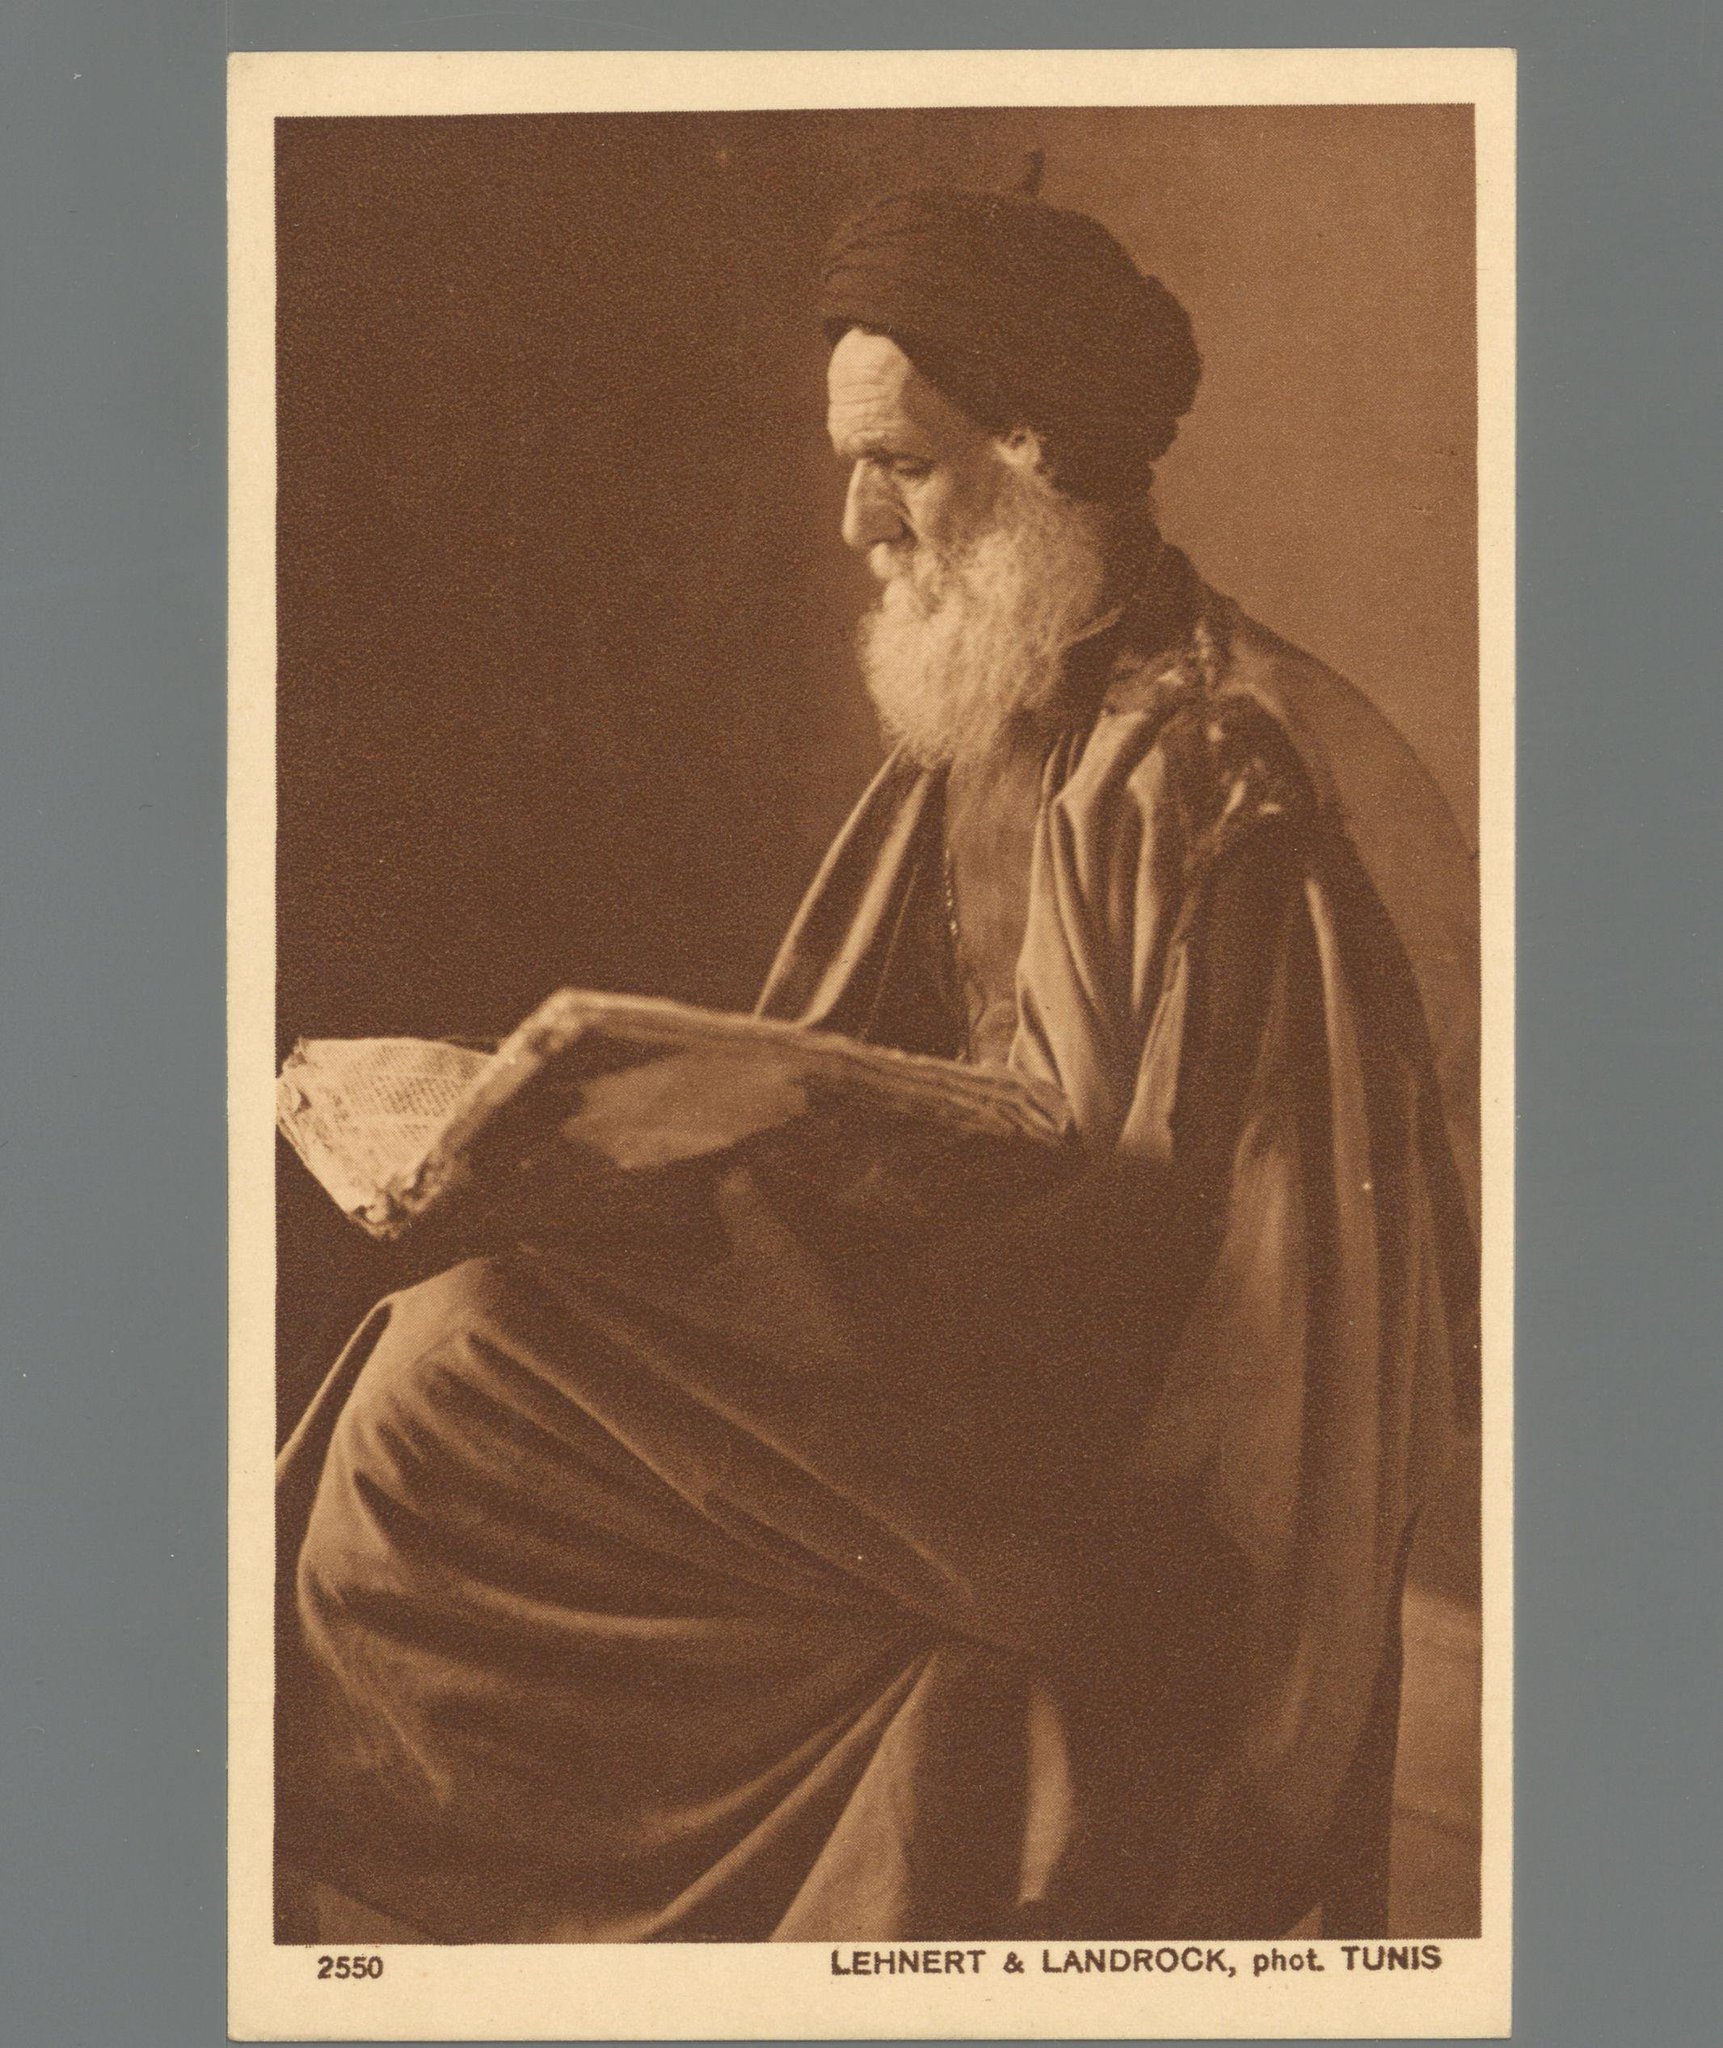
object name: ansichtkaart, prentbriefkaart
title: Rabbin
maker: Anonymous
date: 1903-1930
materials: cardboard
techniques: rotogravure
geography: tunisia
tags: head-gear: turban, rabbi, historical persons (portraits and scenes from the life)